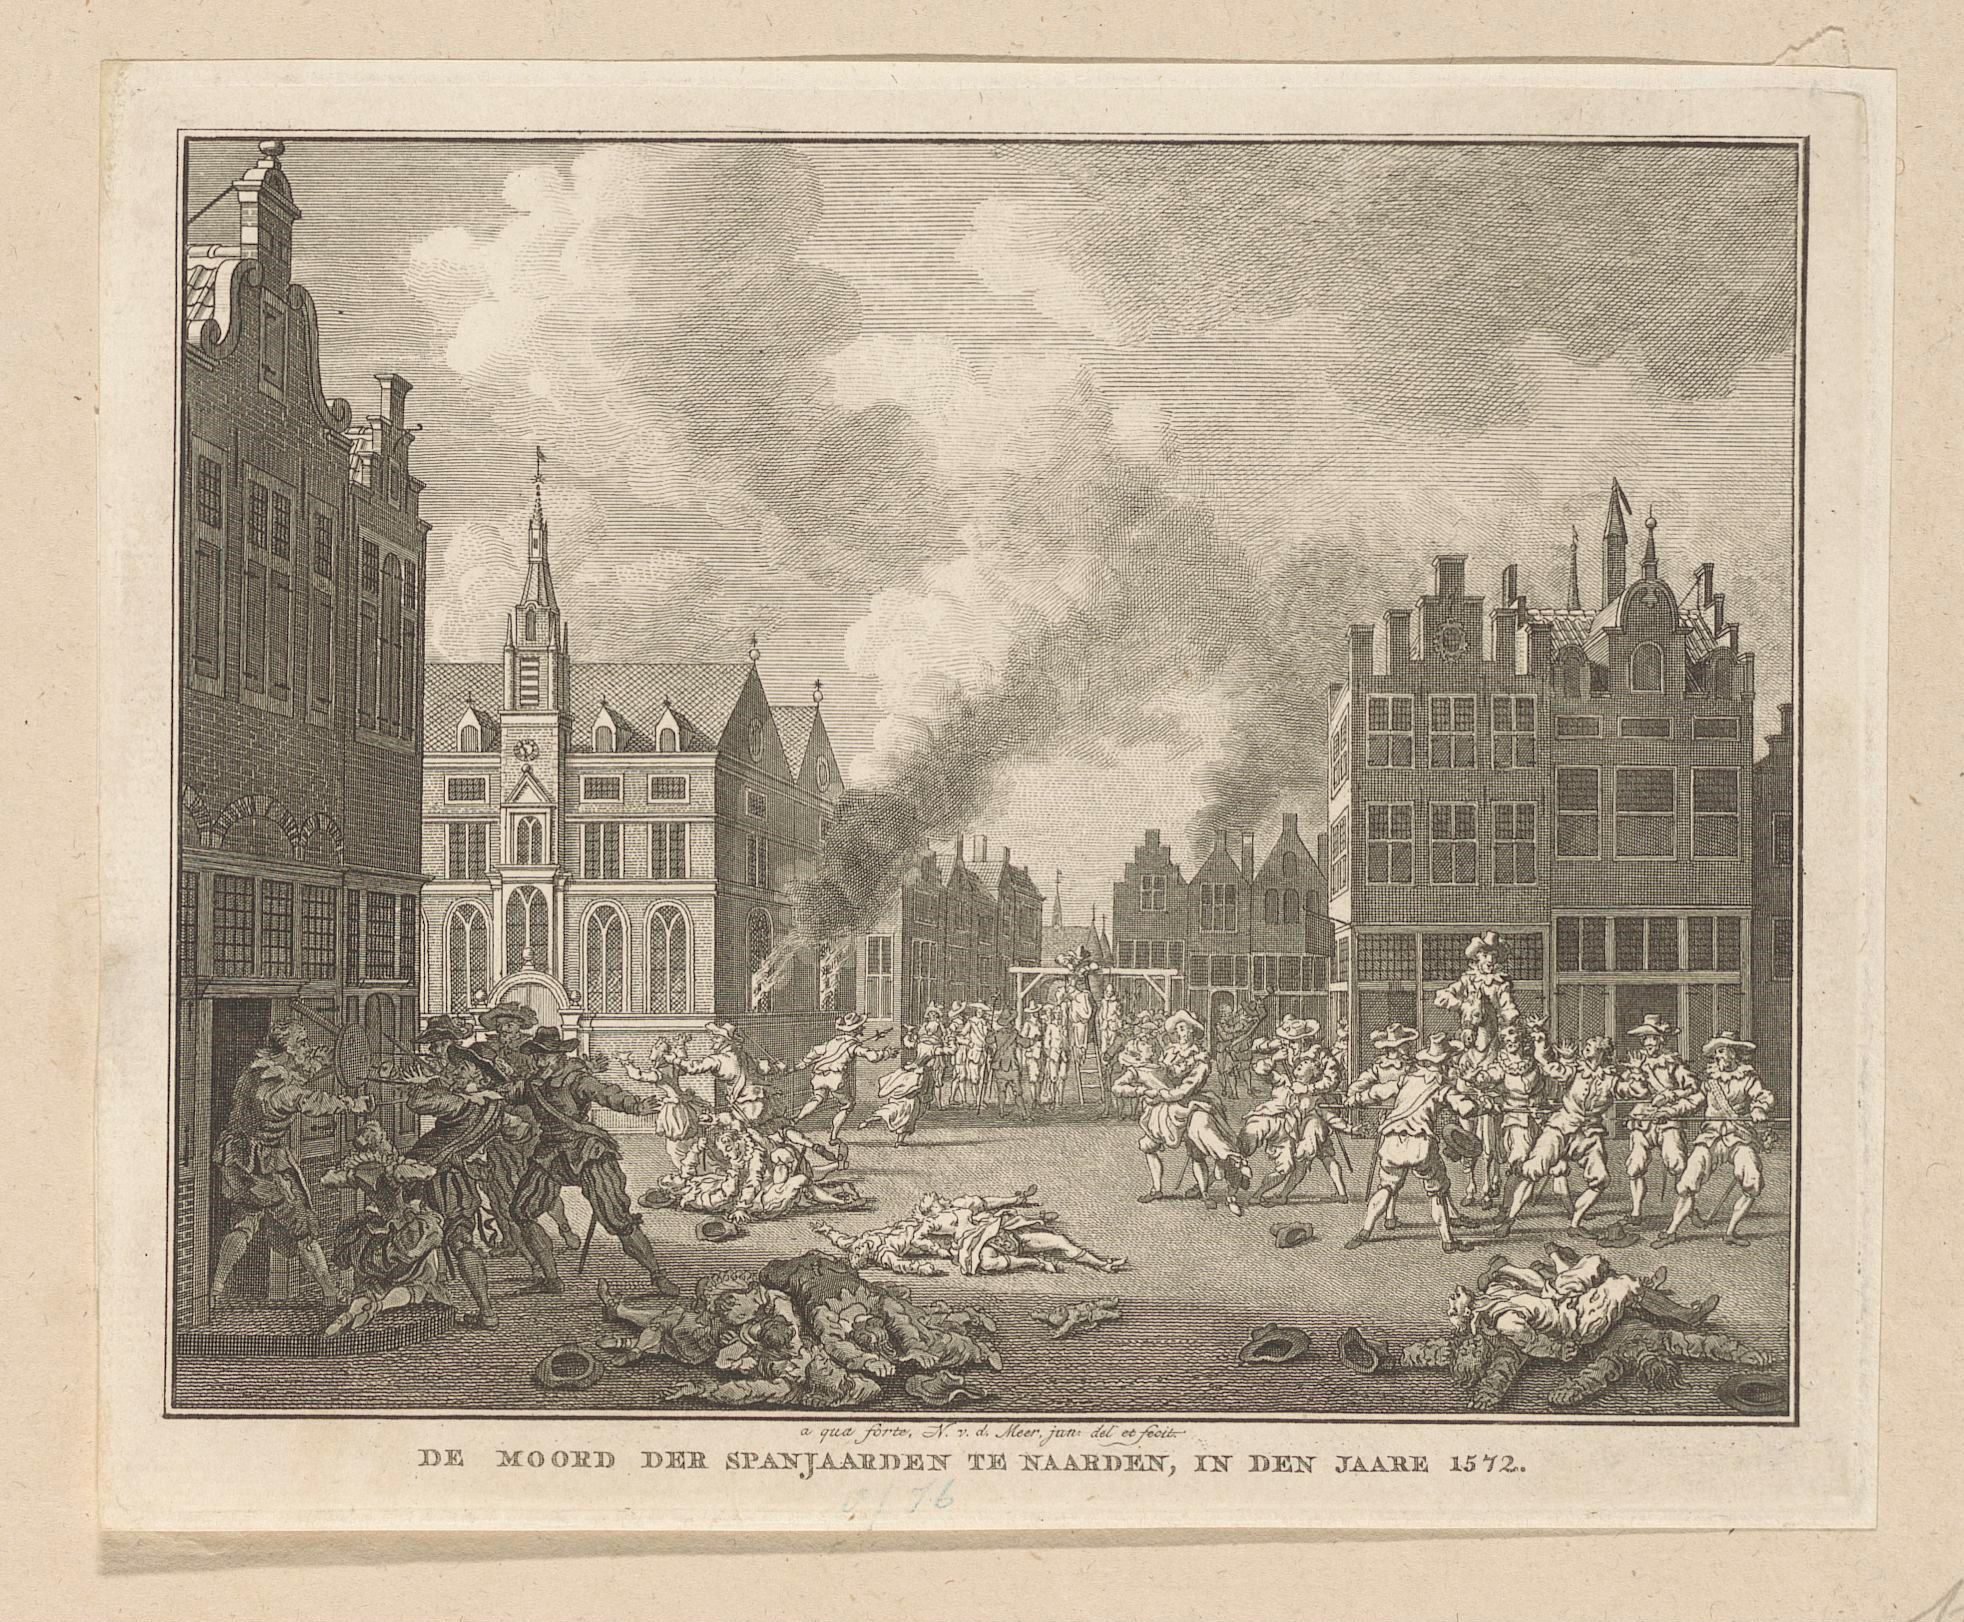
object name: print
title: De moord der Spanjaarden te Naarden, in den jaare 1572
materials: paper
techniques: etching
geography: amsterdam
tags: setting on fire (of conquered city), destruction of conquered city, massacre ~ war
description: Op 1 december 1572 werd een groot deel van de bevolking van Naarden door de Spanjaarden vermoord, nadat de stad zich aan de Spaanse troepen had overgegeven. Op het stadsplein worden burgers neergeschoten en opgehangen. Op straat liggen lijken en de huizen staan in brand.